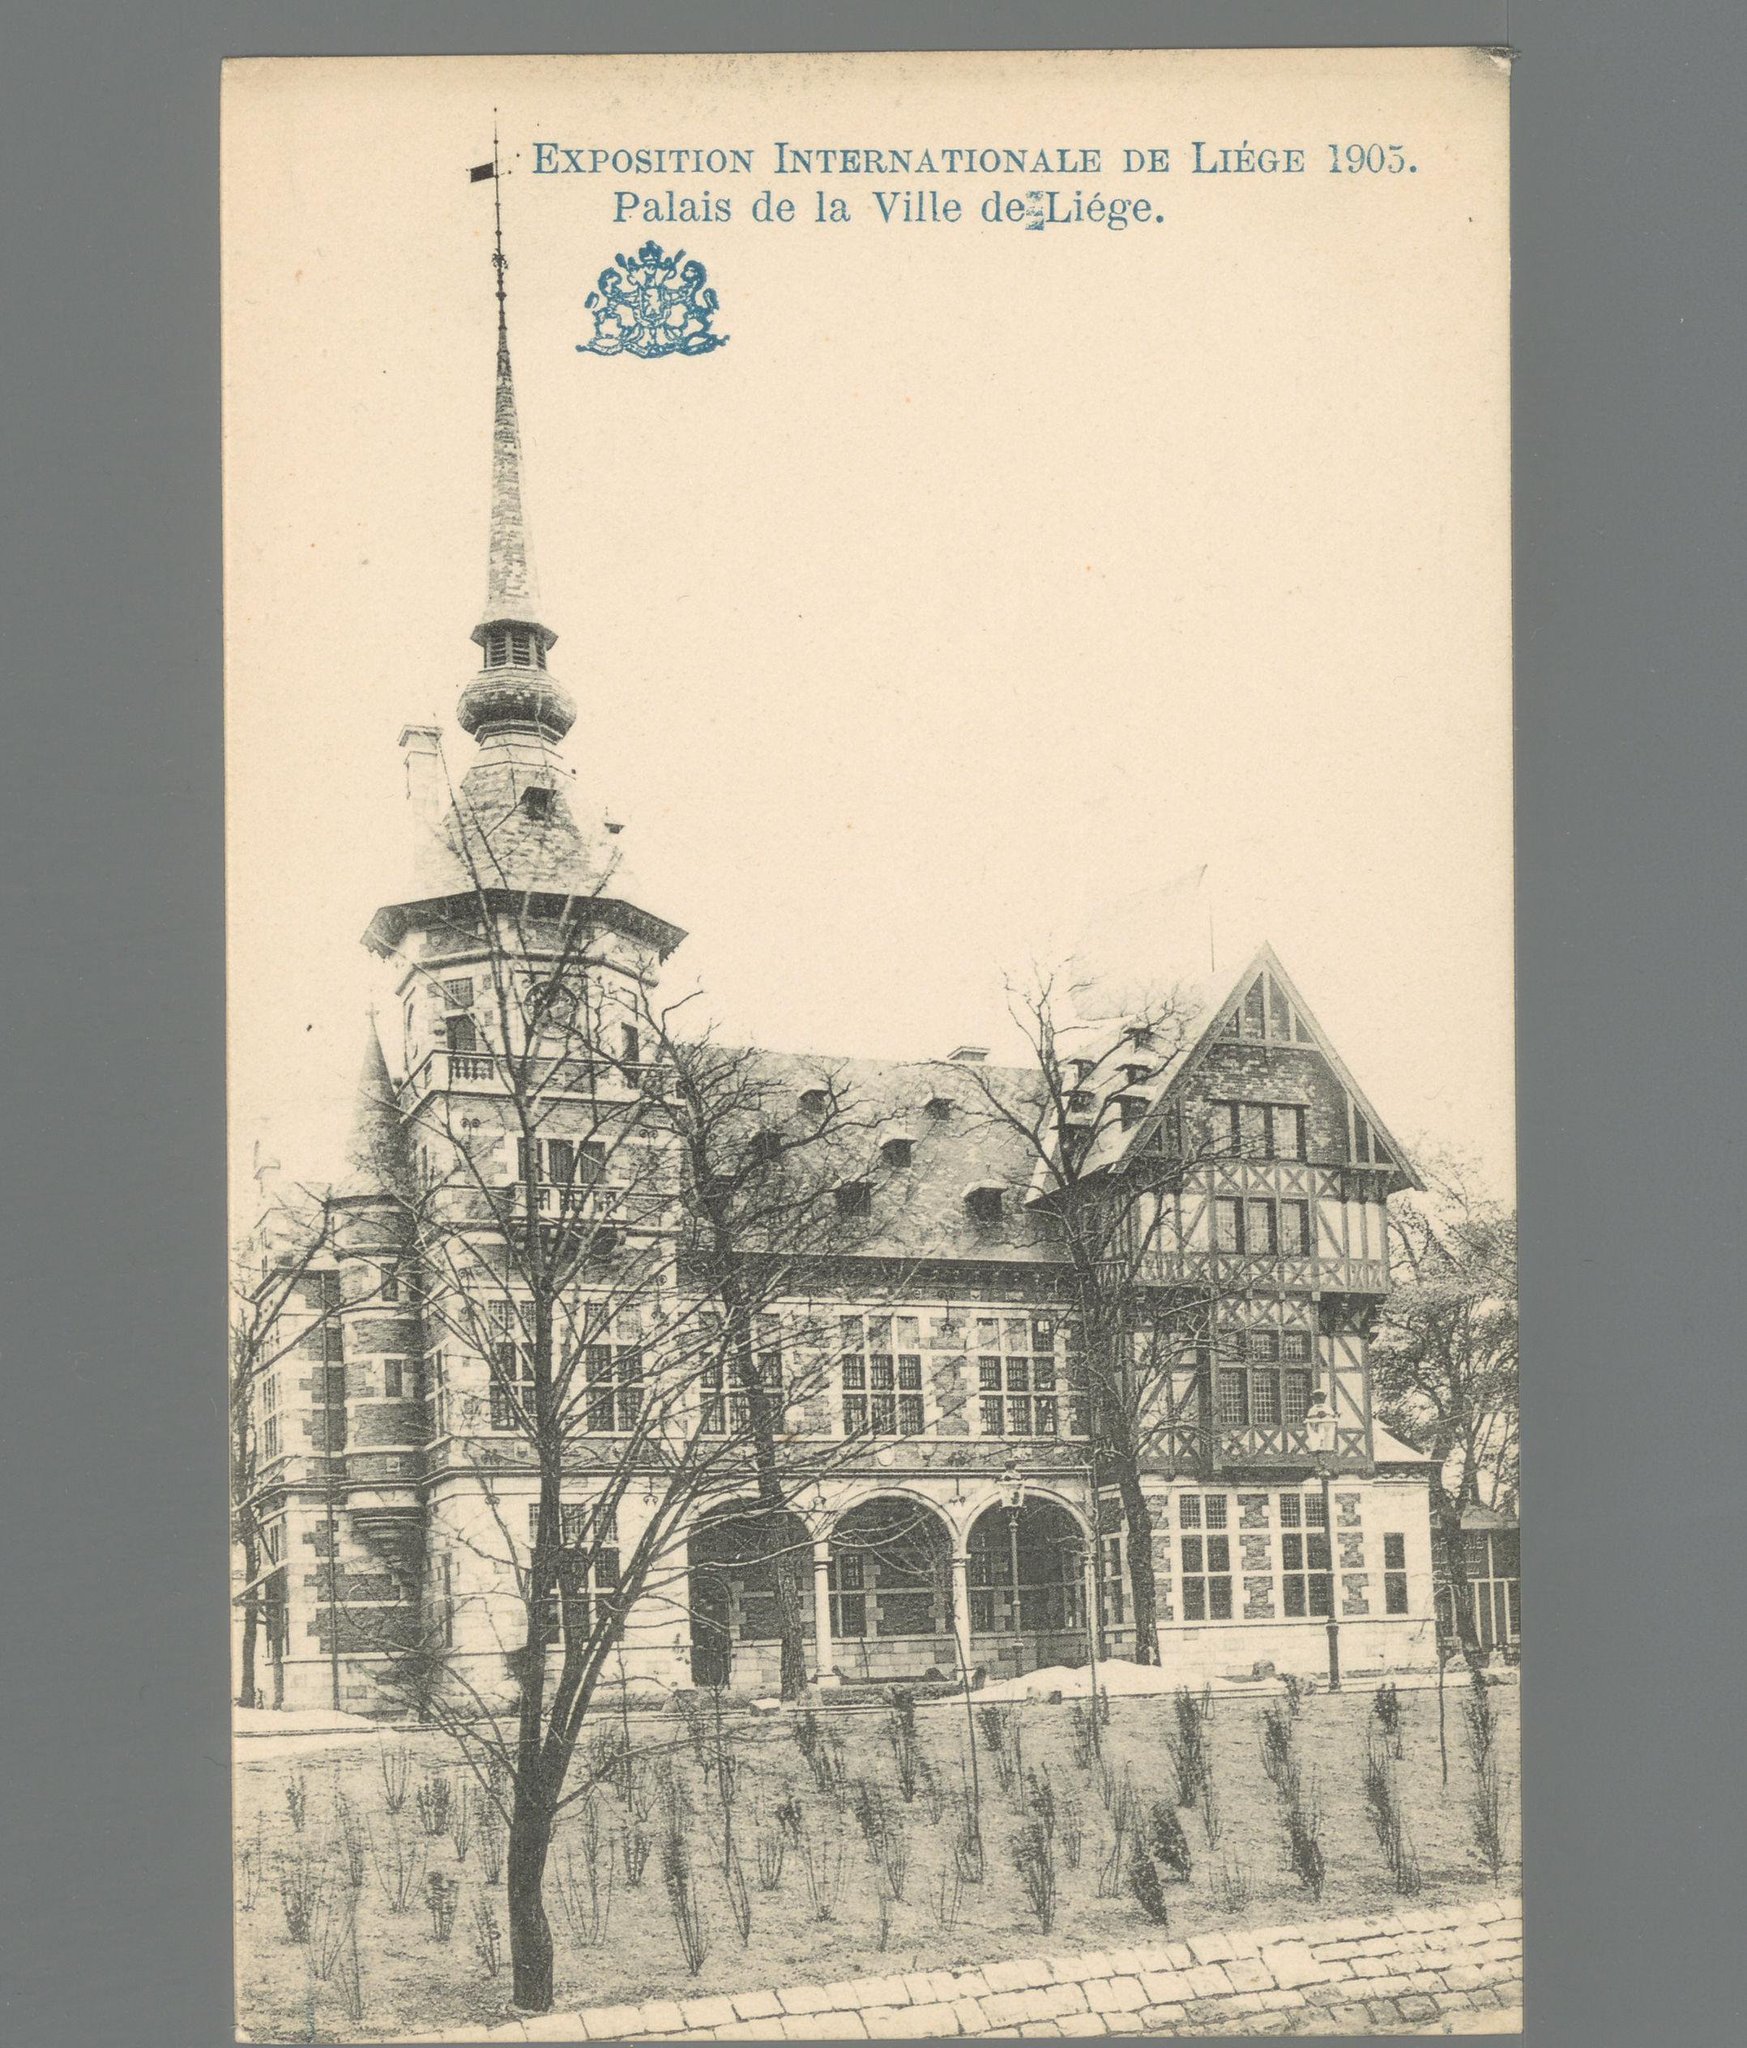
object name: photomechanical print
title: Palais de la Ville de Liège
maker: Anonymous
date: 1905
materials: cardboard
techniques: photograph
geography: liège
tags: world fair, world exhibition, public gardens, park, edifice, e.g.: public building, department store, liège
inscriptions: date